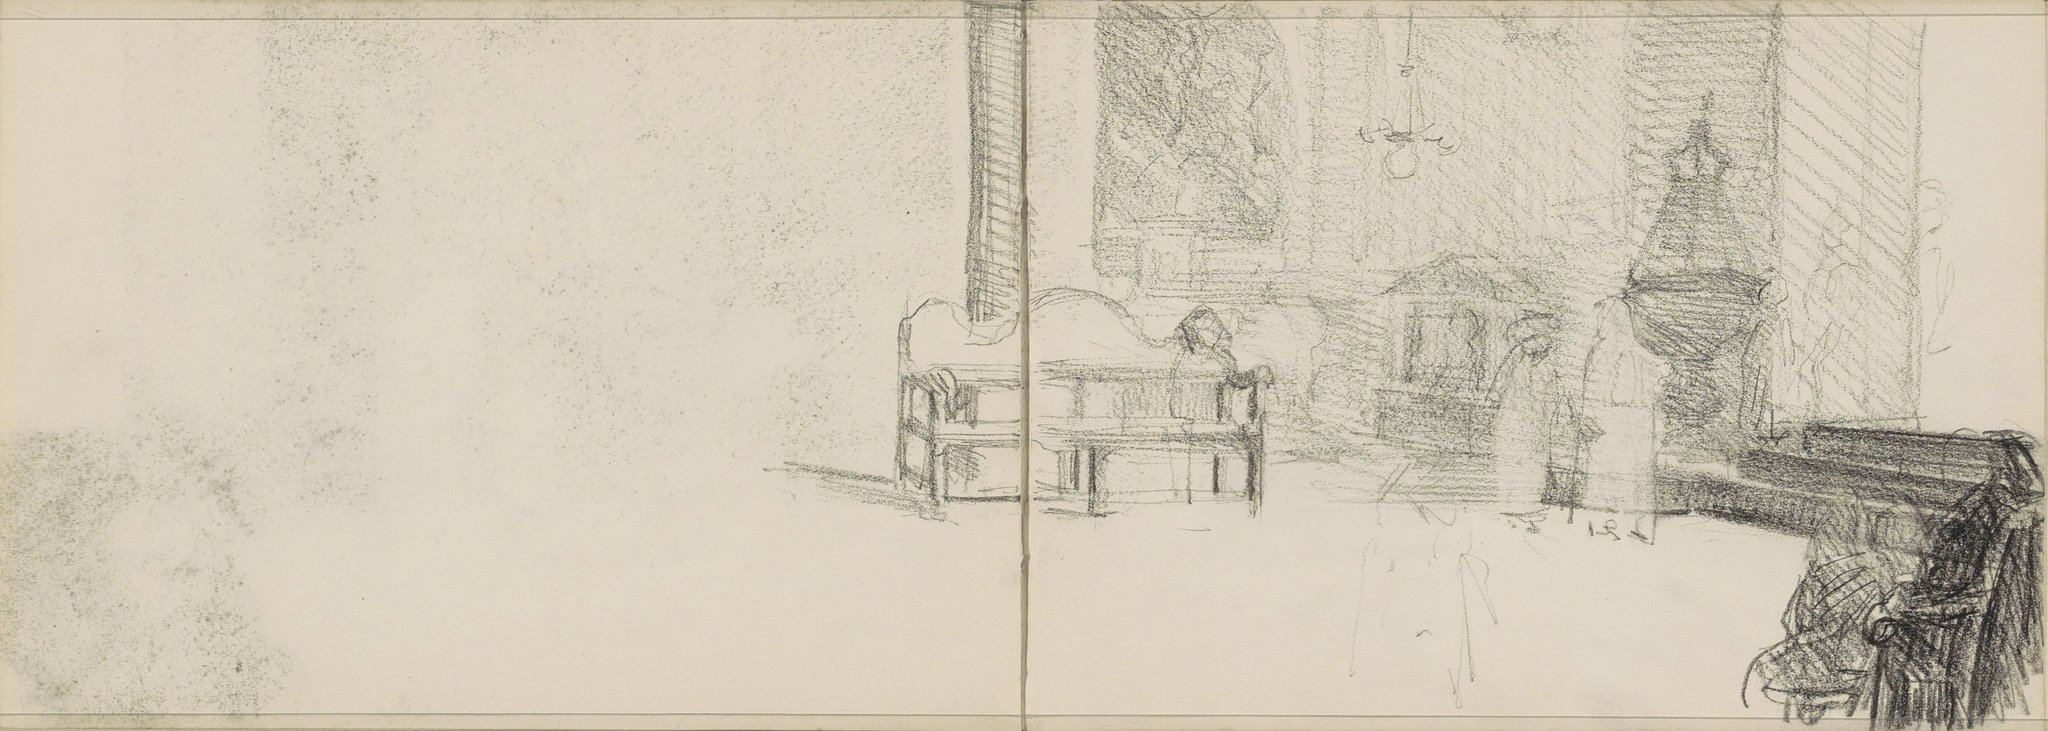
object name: sketchbook leaf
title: Kerkinterieur met figuren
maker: a.a.l. de grammont-hubrecht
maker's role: draughtsman, painter, print maker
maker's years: 1855-1913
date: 1865-1913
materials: chalk, paper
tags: standing figure, interior of church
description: Blad 46 verso en 47 recto uit een schetsboek met 68 bladen.